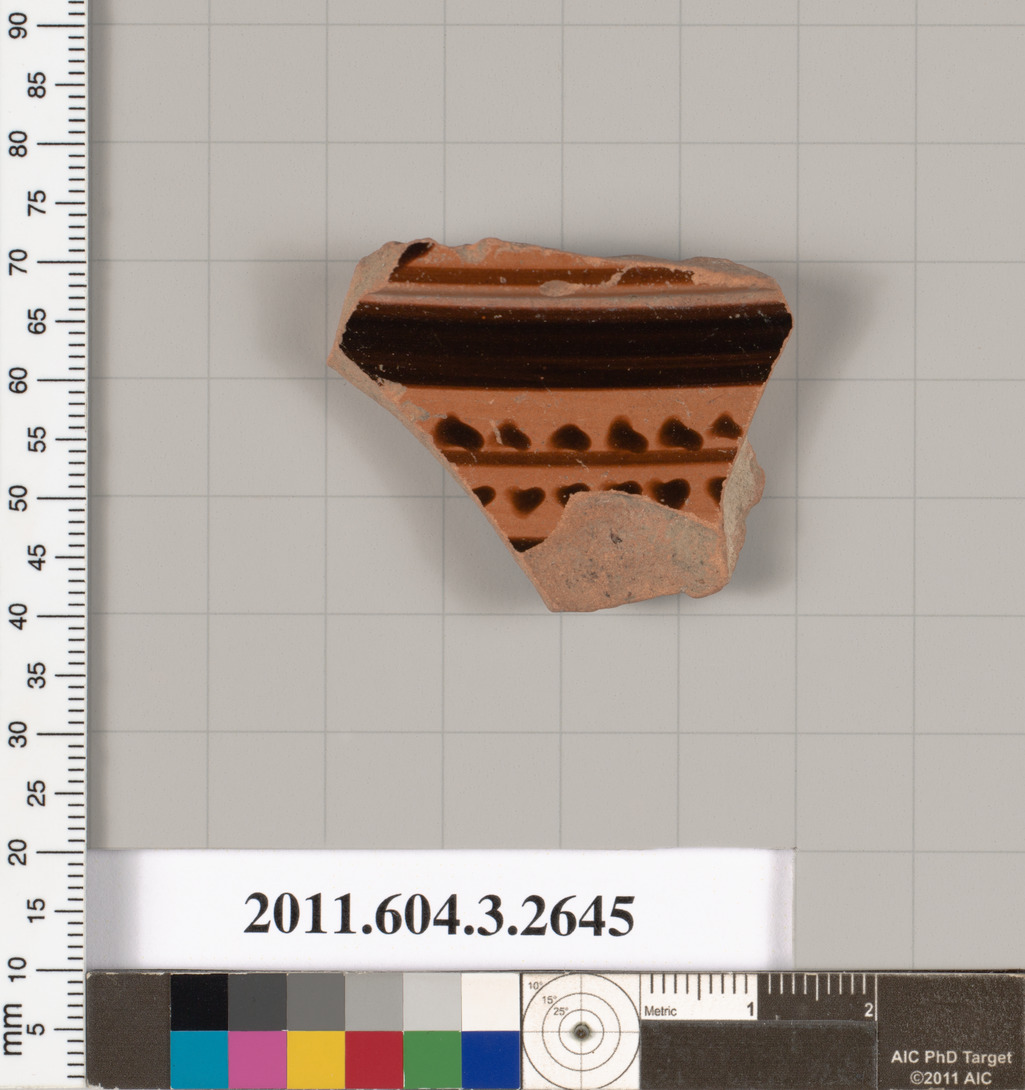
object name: krater fragment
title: Terracotta fragment of a column-krater (bowl for mixing wine and water)?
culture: greek, attic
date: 534-501 BCE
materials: terracotta